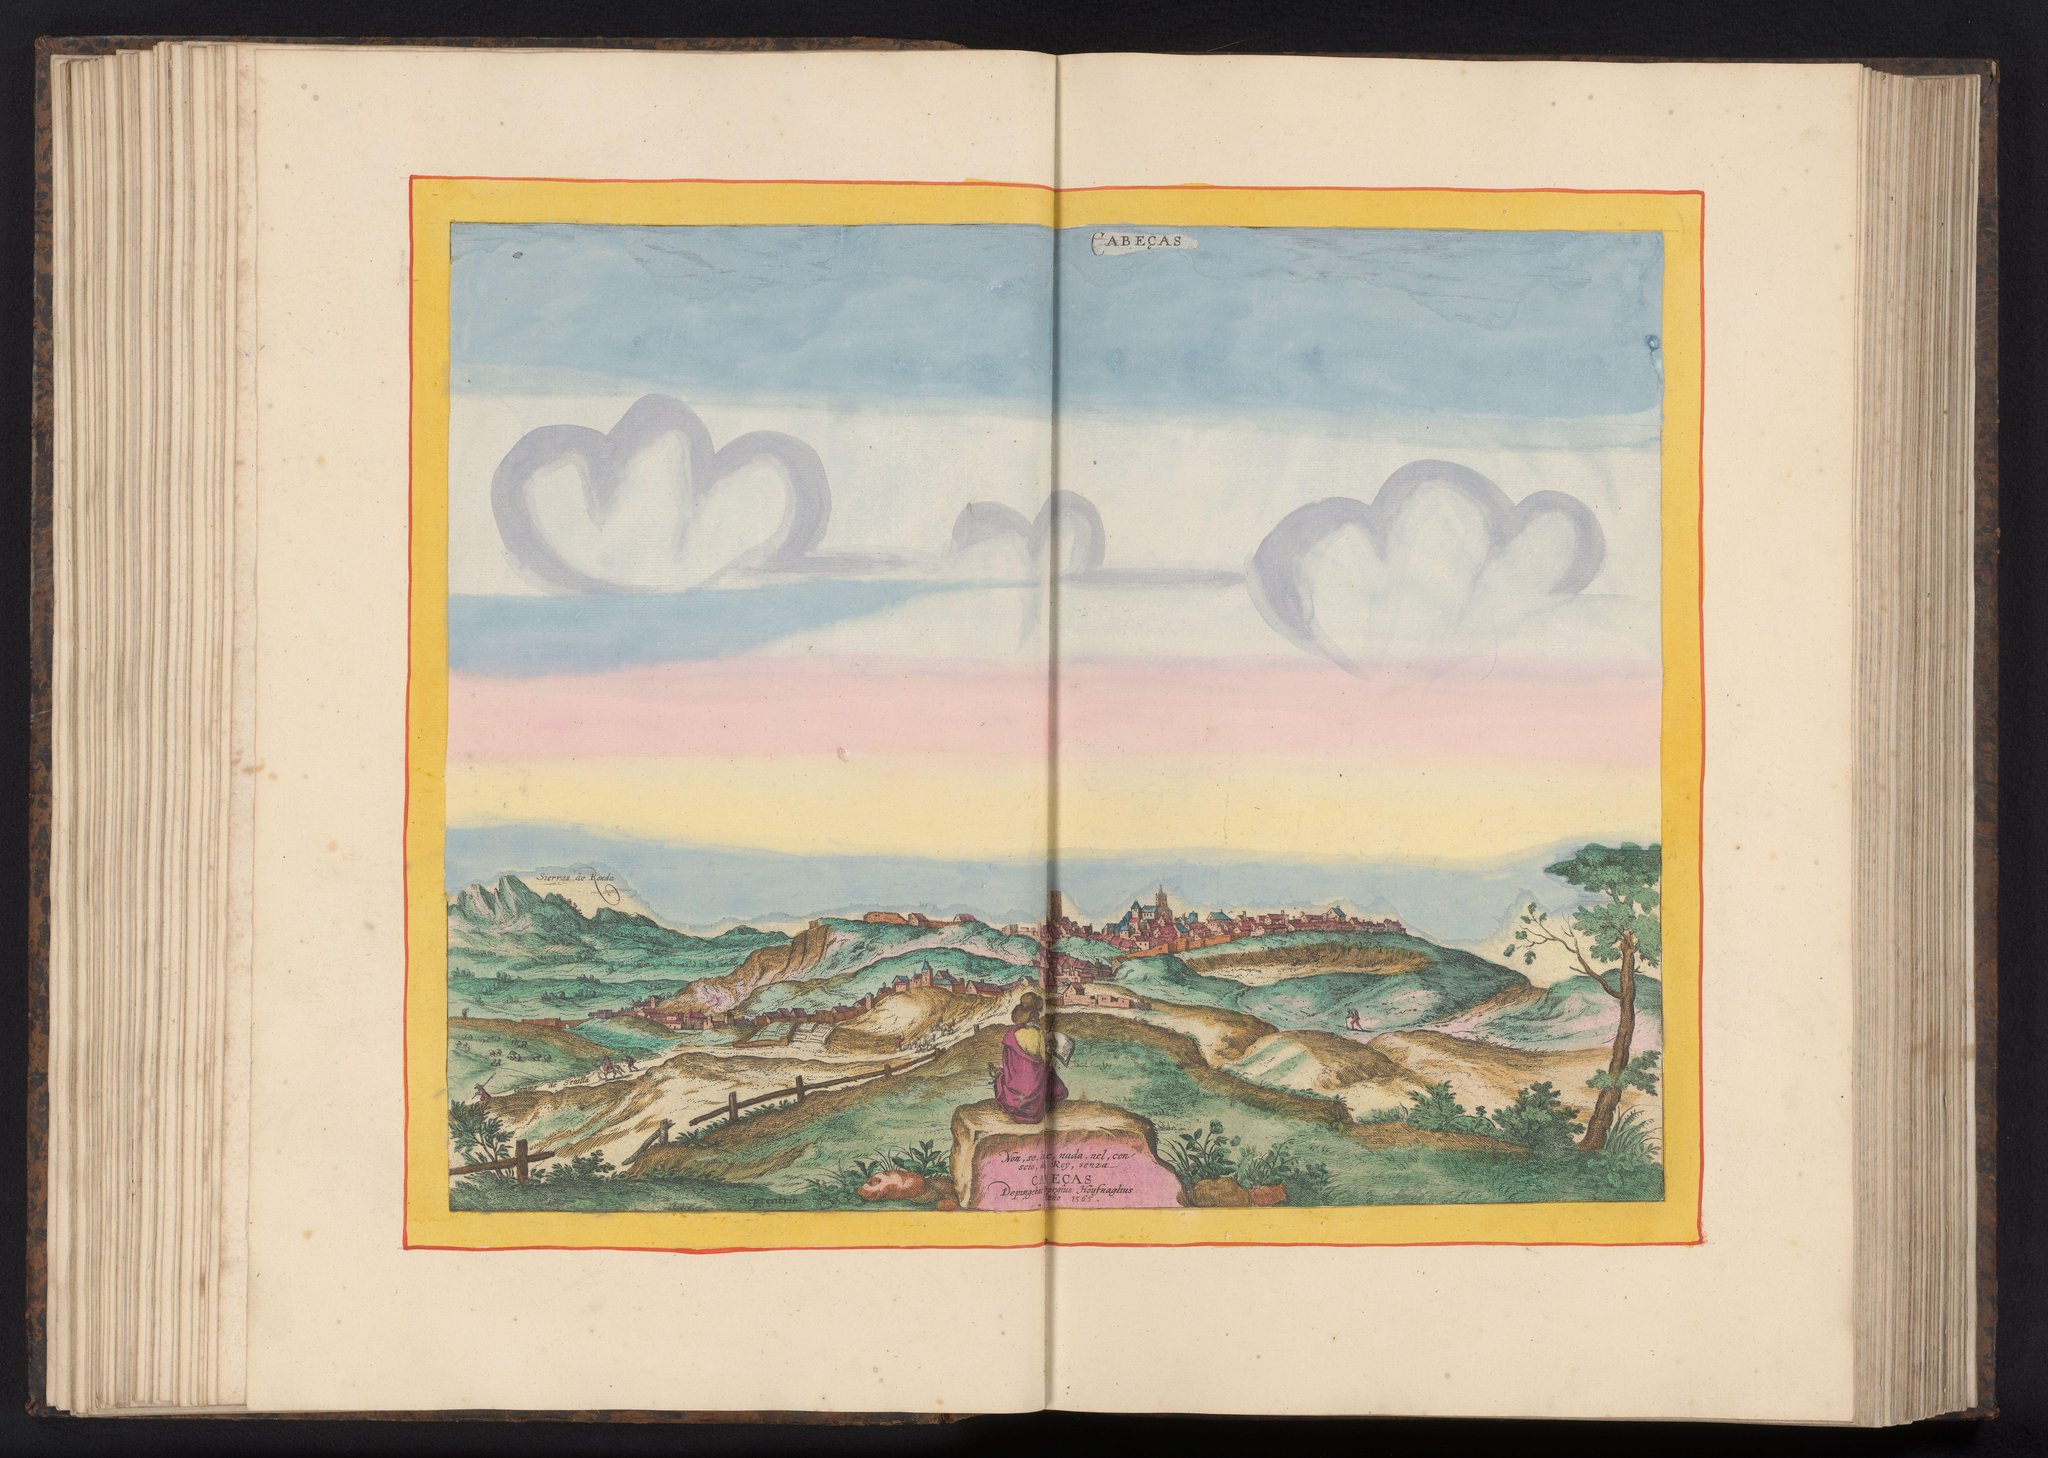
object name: print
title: Gezicht op de stad Las Cabezas de San Juan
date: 1565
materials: paper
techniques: engraving, etching, hand coloring, letterpress printing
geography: the hague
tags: city-view in general; 'veduta', draughtsman at work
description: Prent origineel vervaardigd als boekillustratie voor: Georg Braun en Frans Hogenberg. Civitates Orbis Terrarum, 6 delen. Keulen: 1572-1617. De prent werd voor het eerst gepubliceerd in deel 5: Urbium praecipuarum mundi theatrum quintum, 1596. De prent is langs de bovenrand van de heuvels afgescheurd. Het bovenste gedeelte met de lucht is hoger opgeplakt, zodat de lucht hoger is geworden en het formaat van de voorstelling past bij de andere groot formaatvoorstellingen in het album.